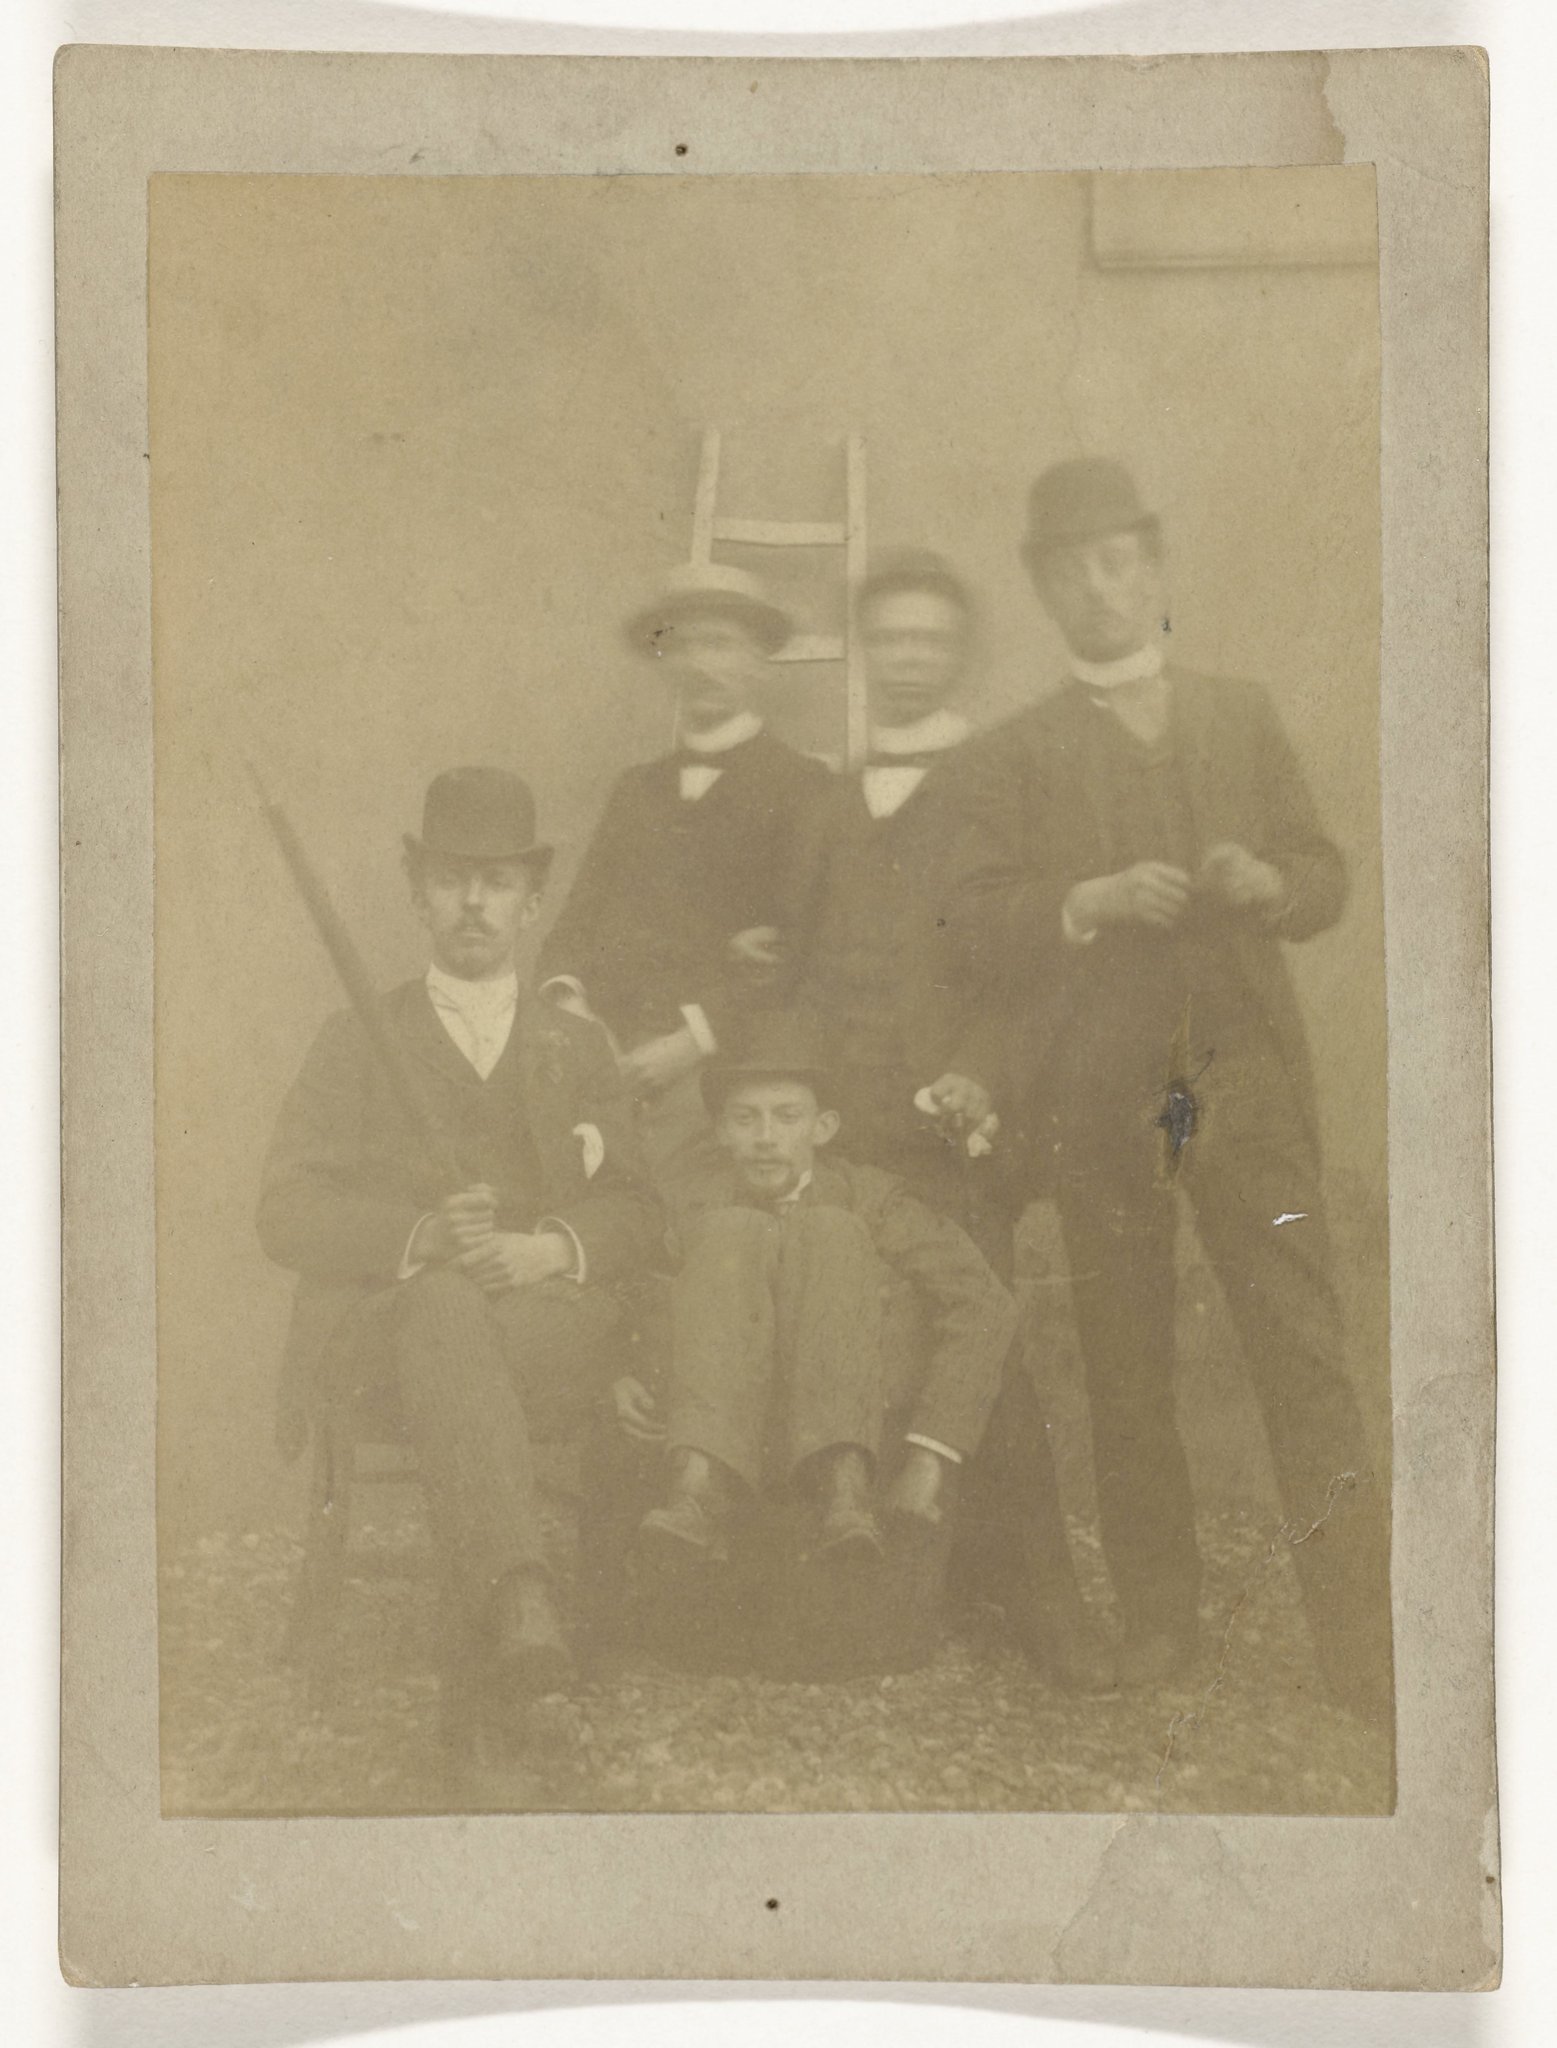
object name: photograph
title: studenten Leiden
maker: israël david kiek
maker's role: fotograaf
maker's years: 1811-1899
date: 1887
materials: cardboard, paper, photographic support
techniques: albumen print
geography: netherlands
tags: anonymous historical persons portrayed in a group, in a group-portrait, leiden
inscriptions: annotation: ‘studenten Leiden’